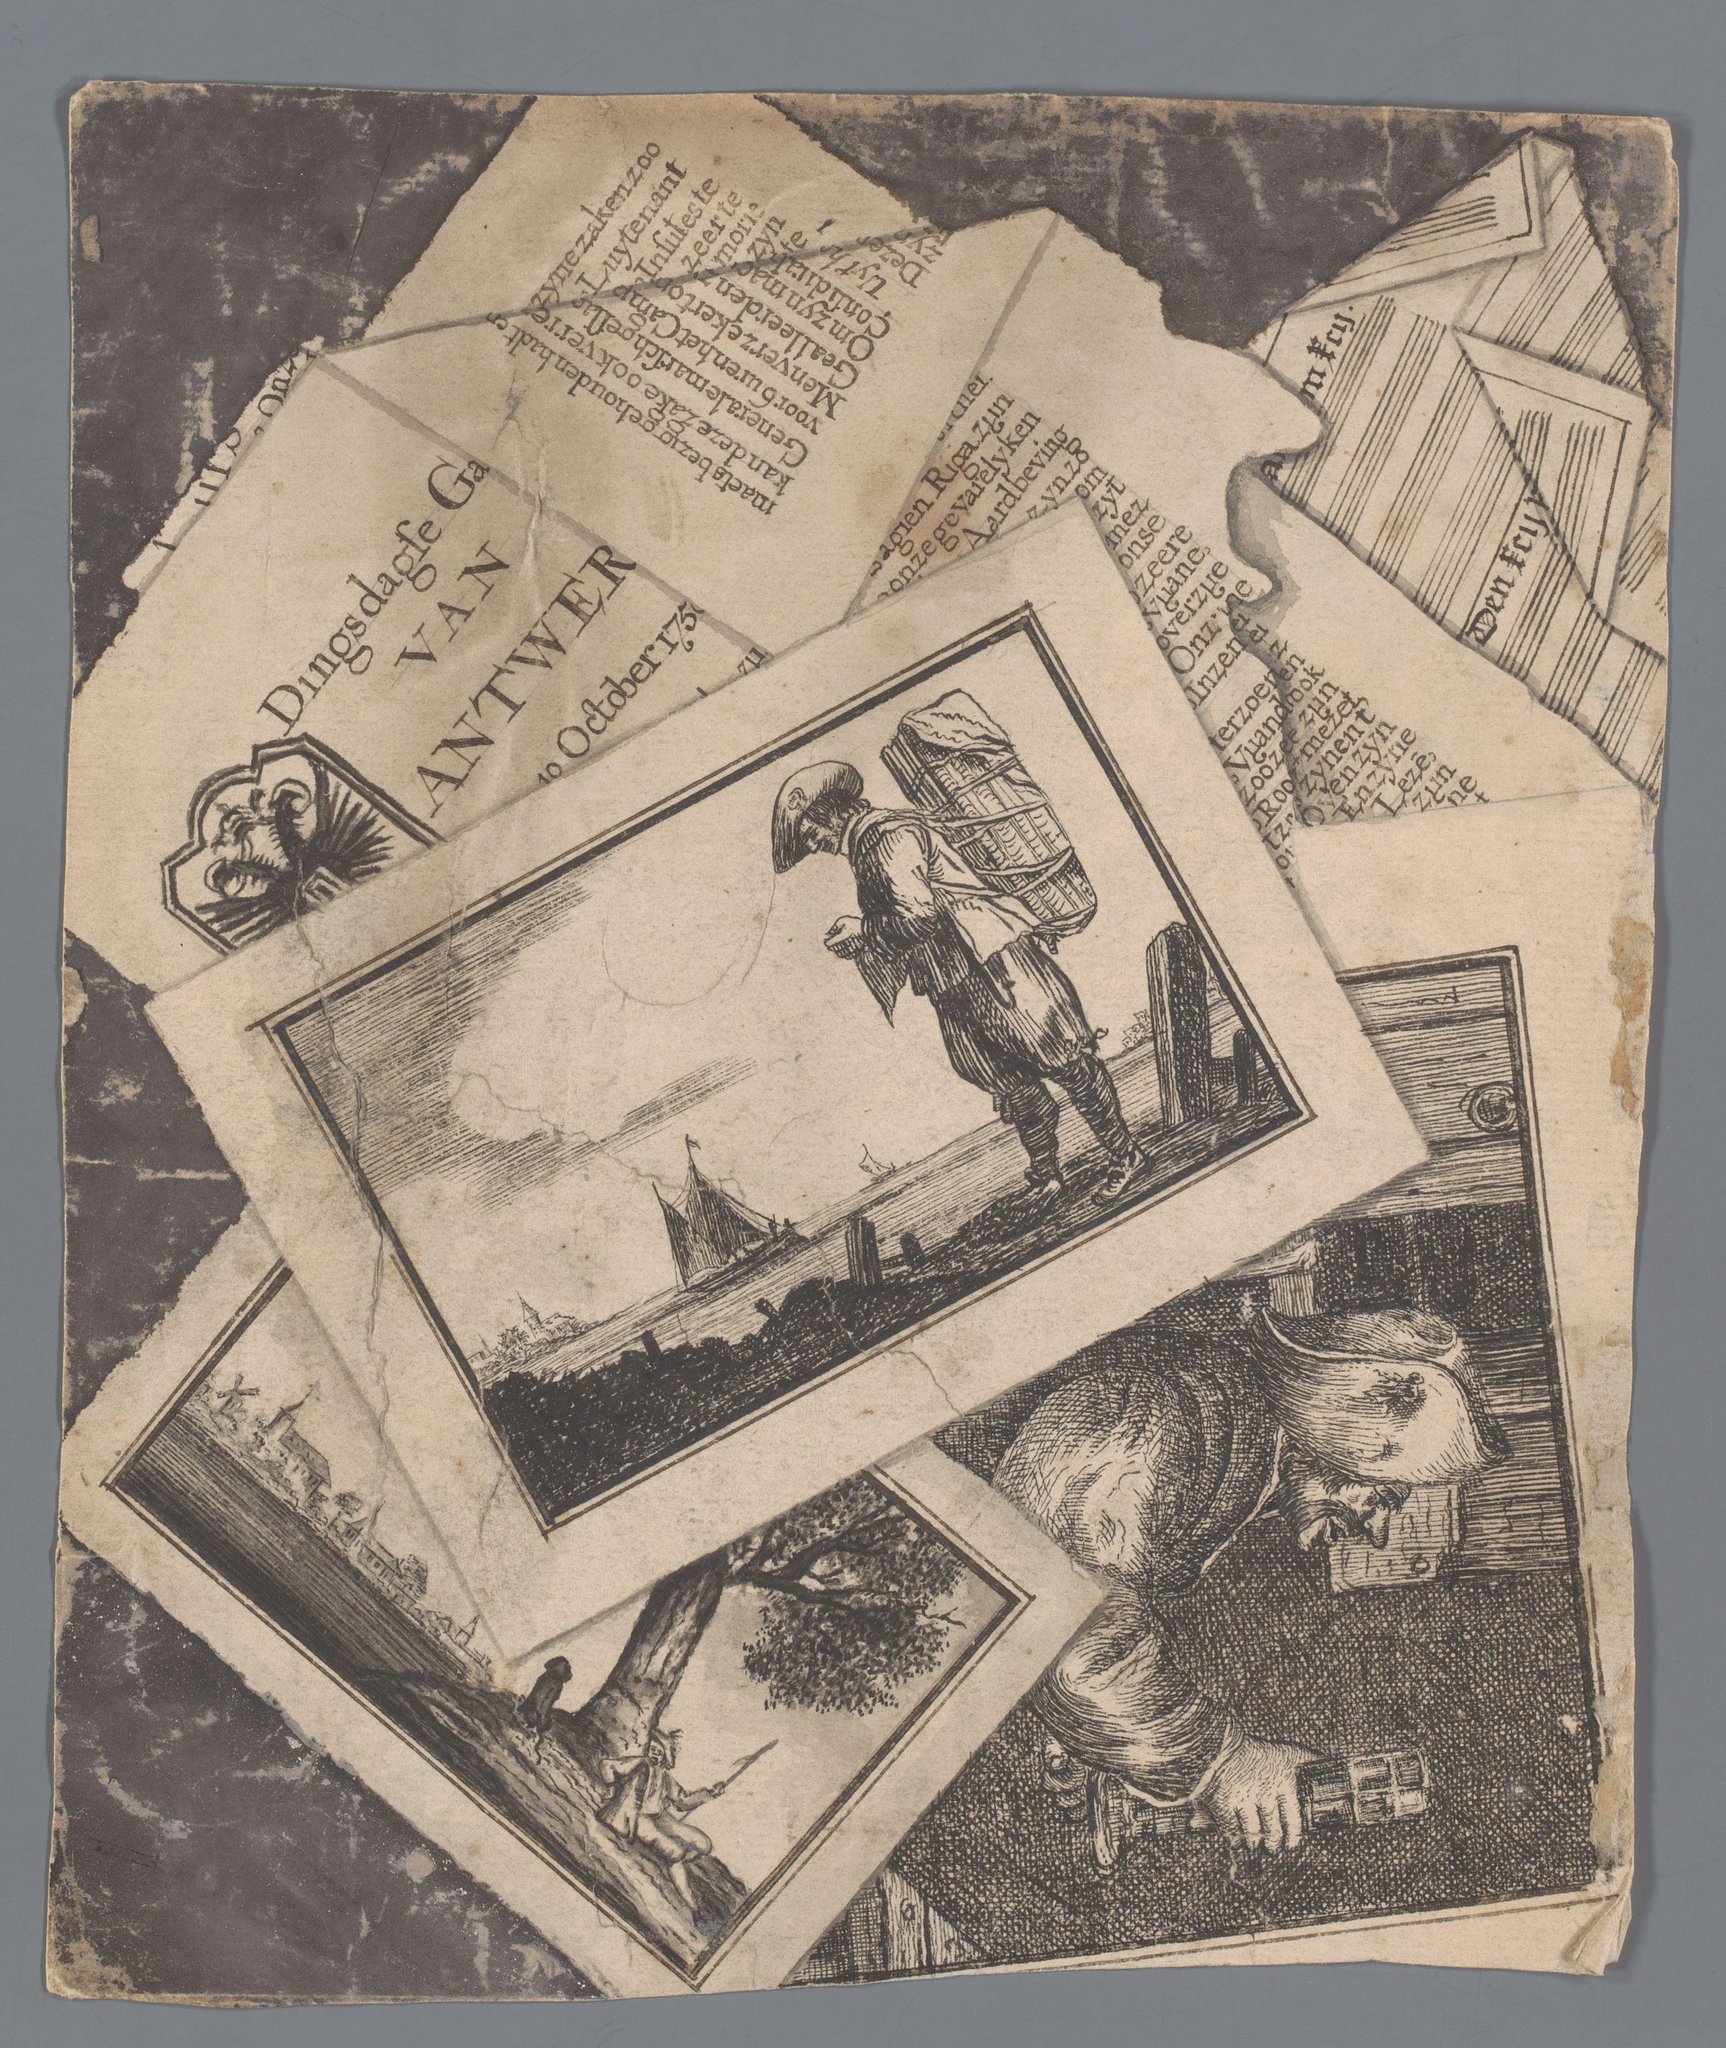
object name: drawing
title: Bedriegertje met prenten, een krant en een blad met muziek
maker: Anonymous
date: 1750-1759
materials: ink, paper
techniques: brush, pen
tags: 'trompe l'oeil', print, e.g.: engraving, etching, lithograph, printed edition of musical score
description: Bedriegertje of trompe l'oeuil met deels over elkaar liggende prenten, een 'Dingsdagse Gazet van Antwerpen' en bladen met blanco notenbalken.